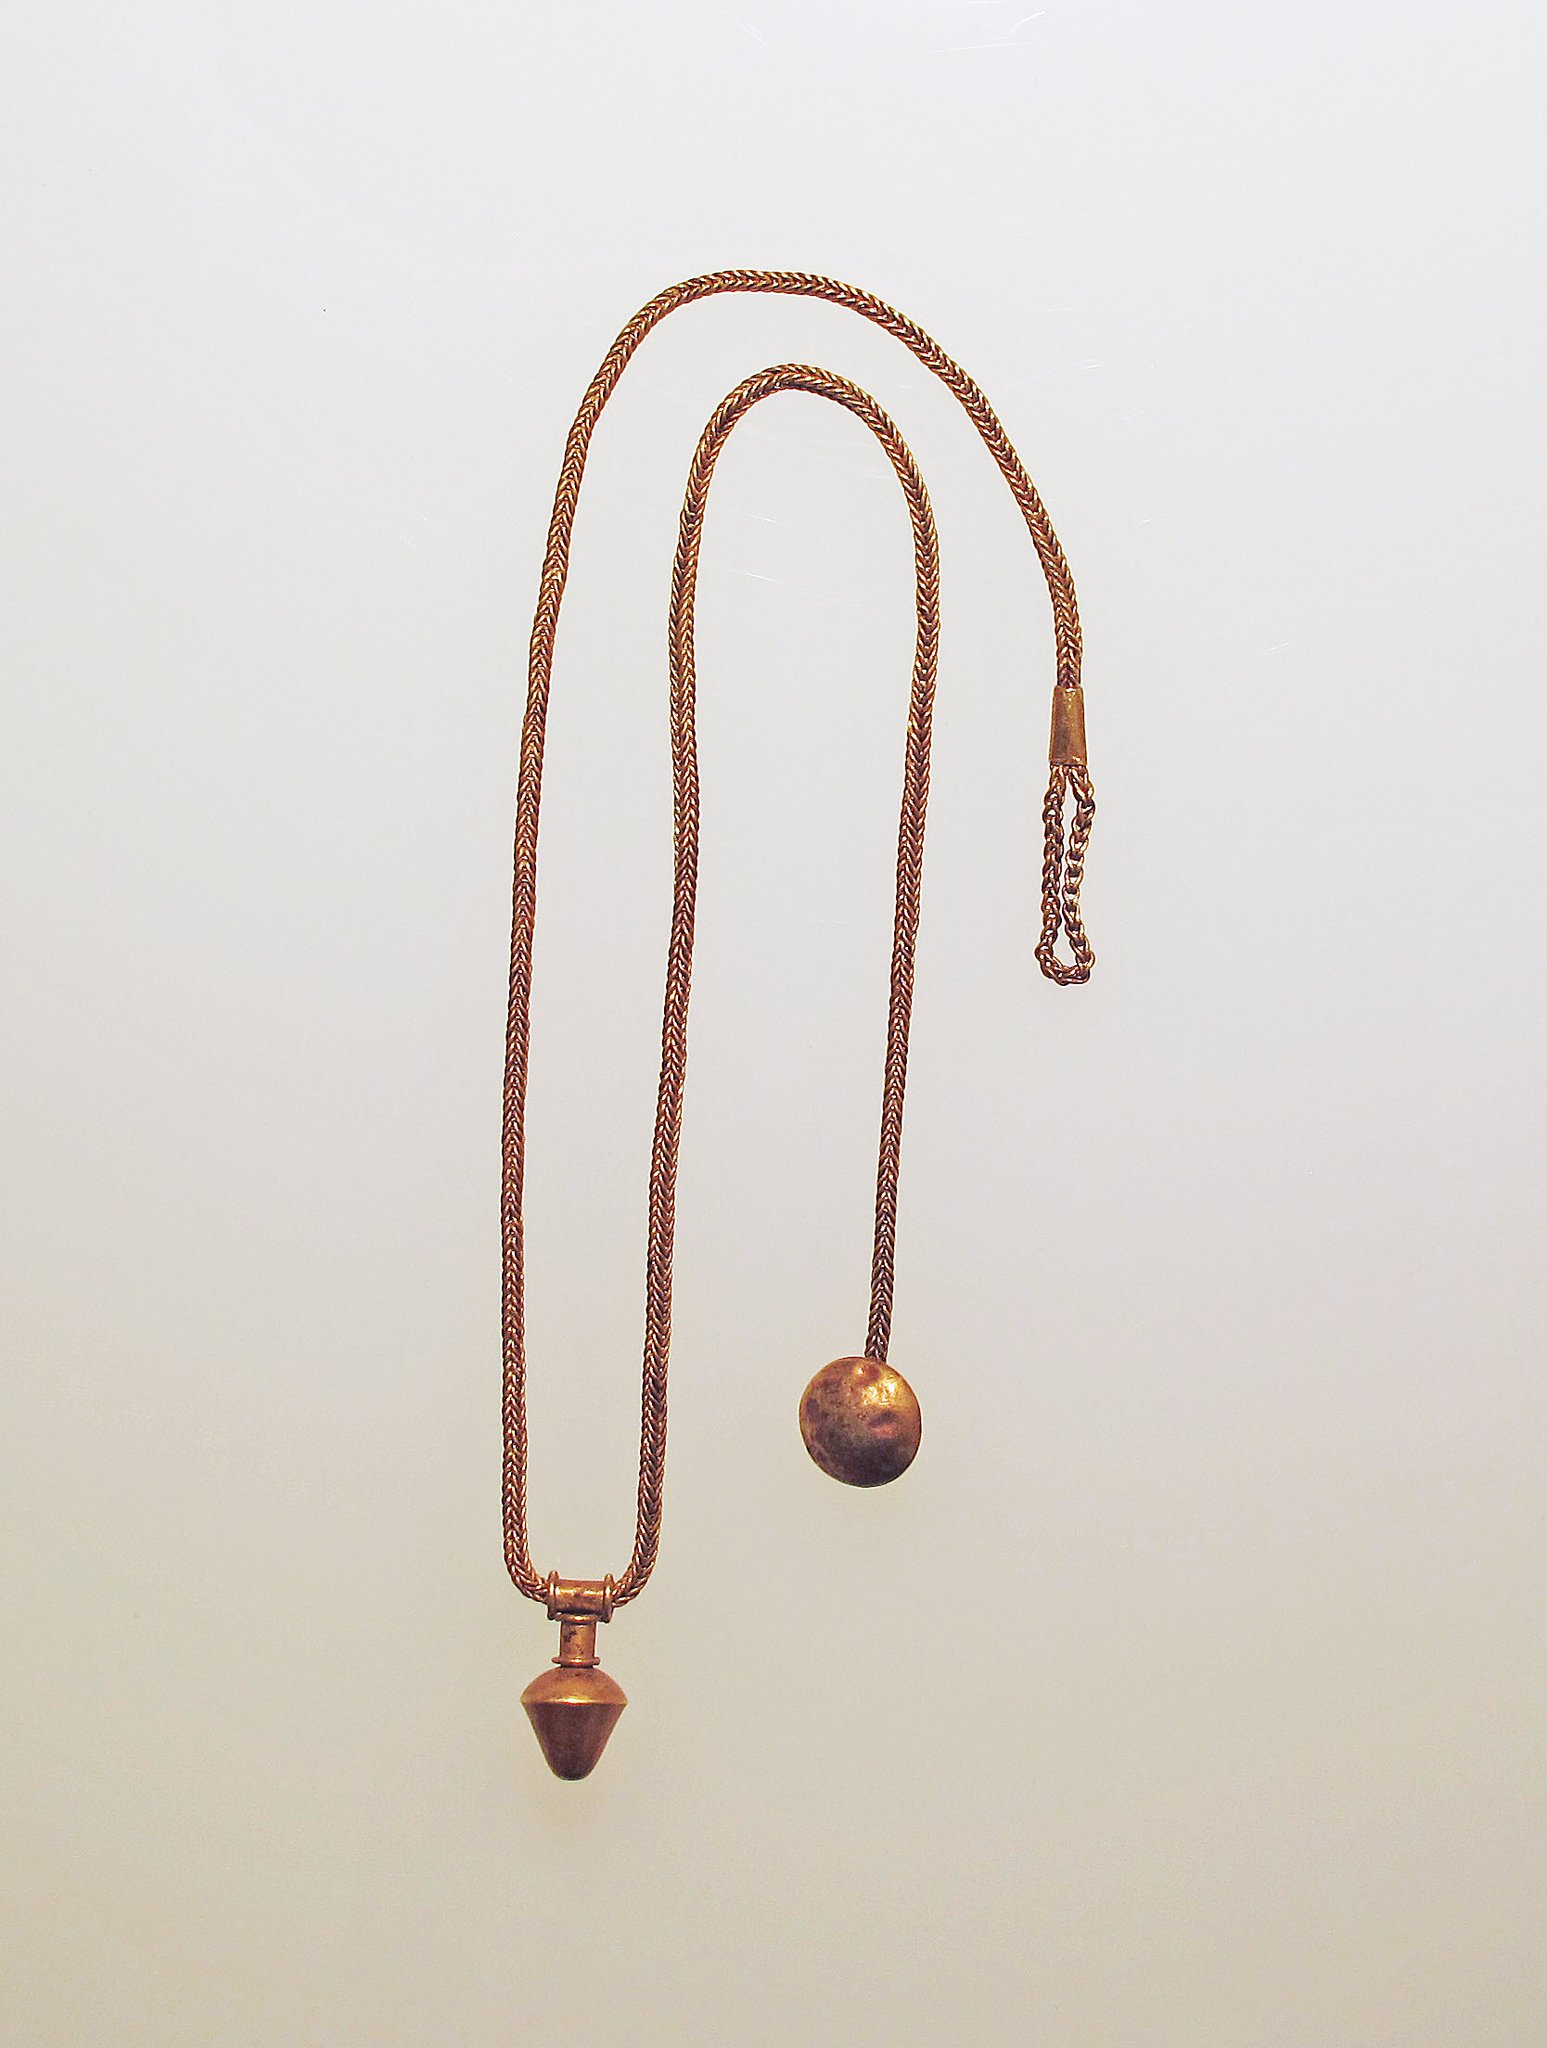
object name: necklace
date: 7000 BCE-330 CE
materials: gold